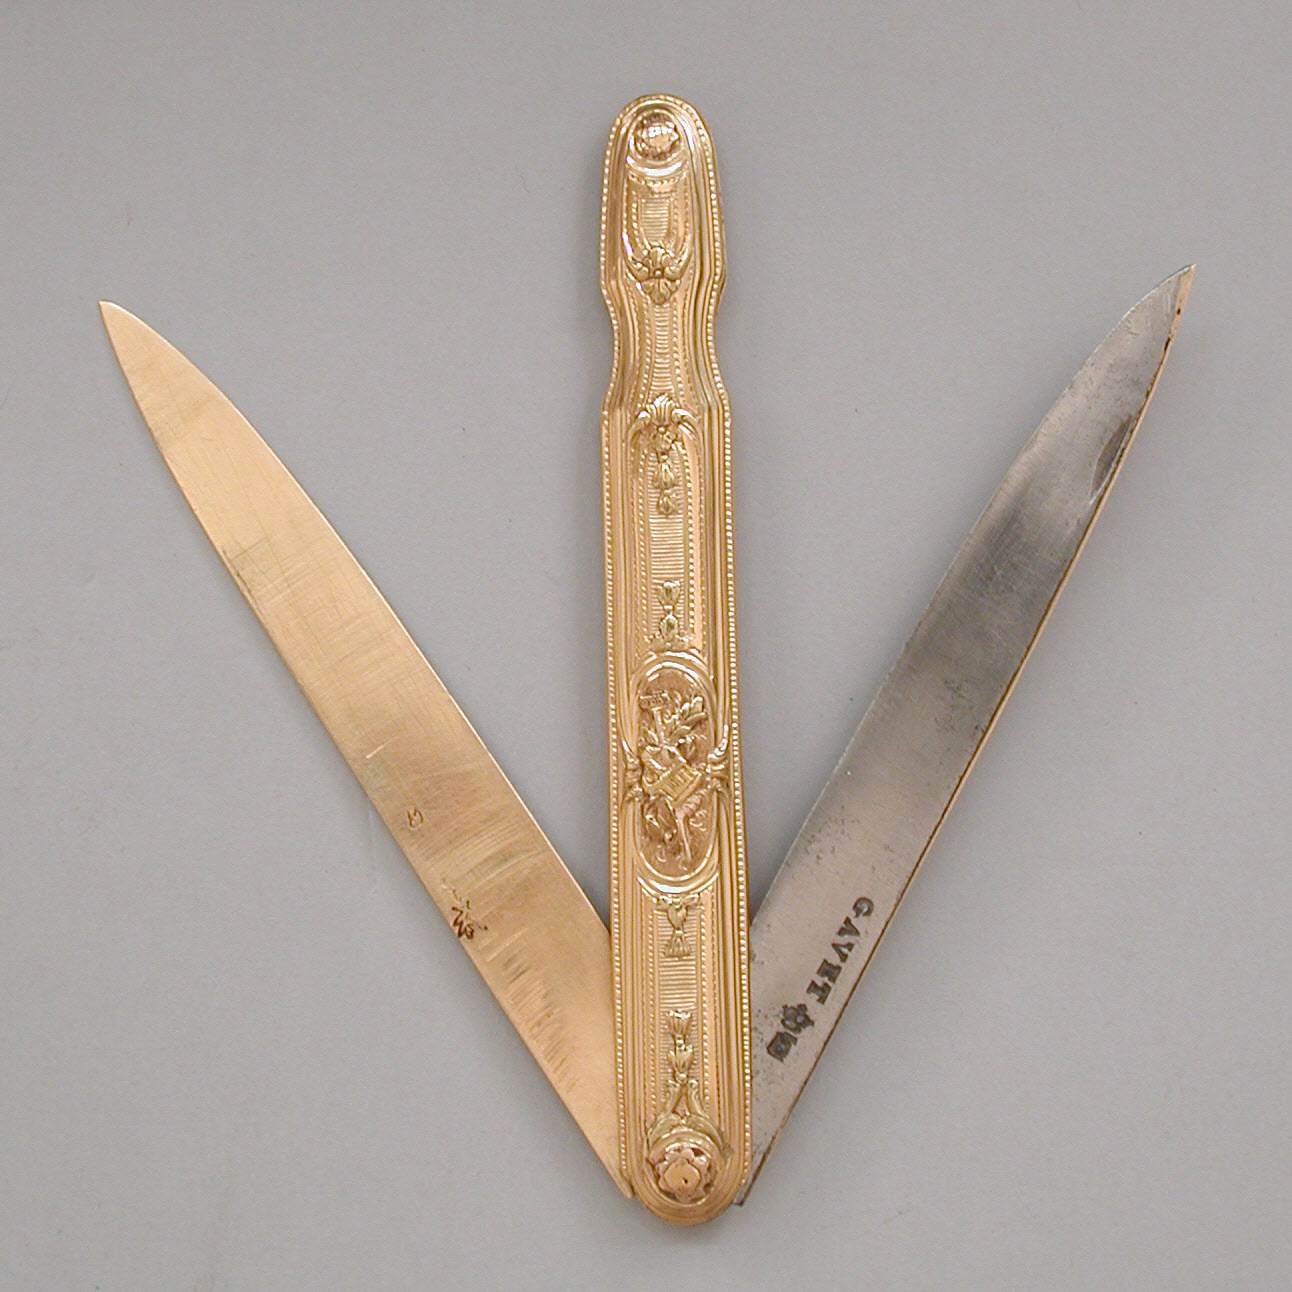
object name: pocket knife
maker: jean gavet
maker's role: maker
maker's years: 1727-1811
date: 1766-1767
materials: gold, steel